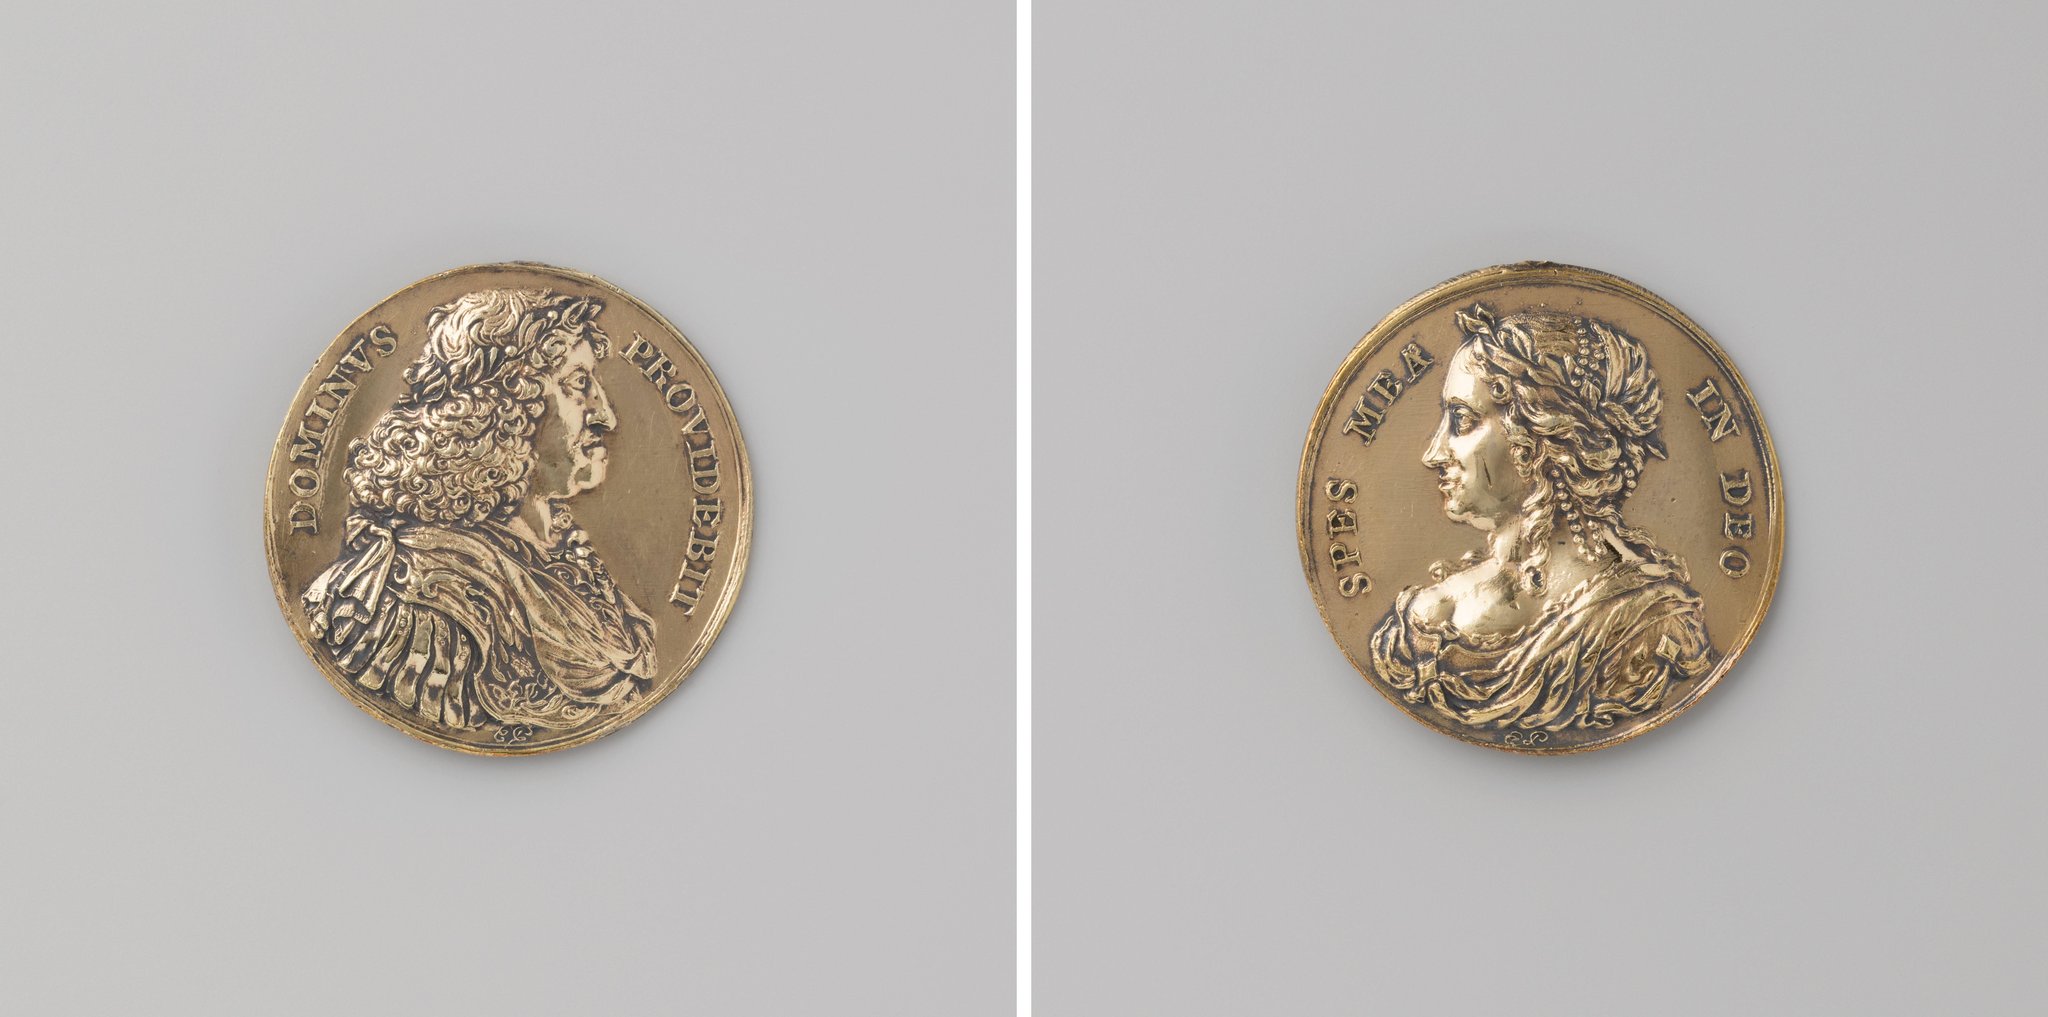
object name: medal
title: Beleg van Kopenhagen door de Zweden, ter ere van Frederik III van Denemarken en zijn vrouw Sophie Amalia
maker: erich parise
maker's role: graveur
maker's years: -1666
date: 1658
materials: silver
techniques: gilding, striking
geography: copenhagen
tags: copenhagen (city), frederik iii (koning van denemarken en noorwegen)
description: Zilveren penning. Voorzijde: borststuk man met lauwerkrans binnen omschrift. Keerzijde: borststuk vrouw met lauwerkrans binnen omschrift